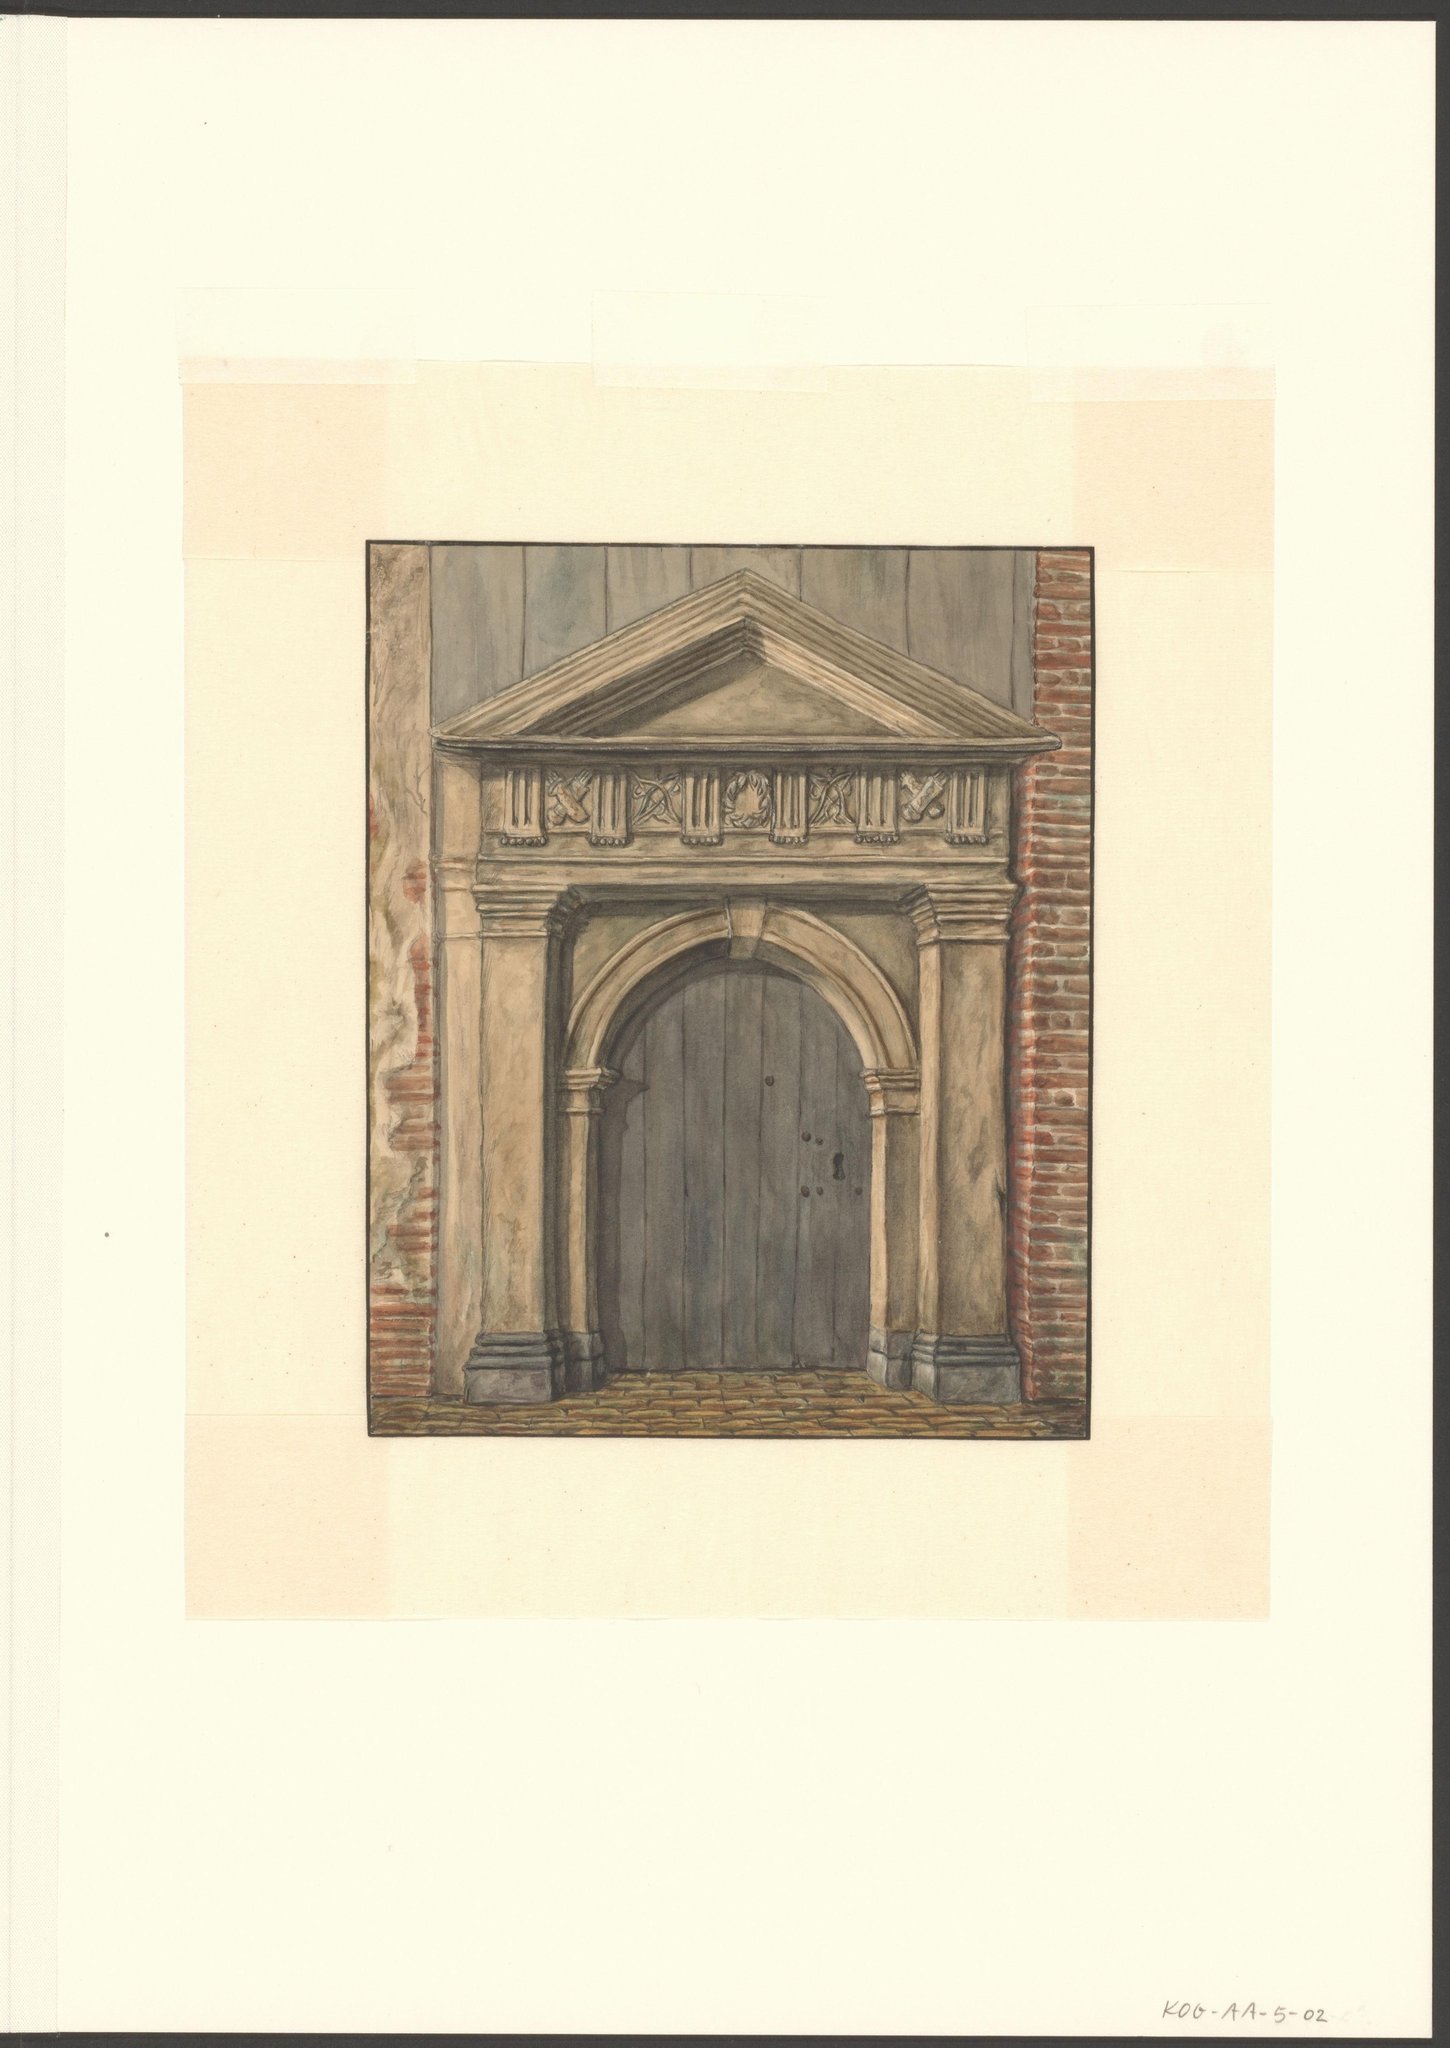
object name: drawing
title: Gezicht op het poortje in de Handboogstraat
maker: jan ter gouw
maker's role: docent, schrijver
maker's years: 1814-1894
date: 1864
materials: ink, paper, pencil, watercolor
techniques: brush, pen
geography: amsterdam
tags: city-view in general; 'veduta', gate, entrance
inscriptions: inscription: ‘Het Poortje in de Handboogstraat, / het eenige overblijfsel van de Handboogs" / doelen.’, number: ‘5’, signature and date: ‘J.E. ter Gouw . fec. 1864’